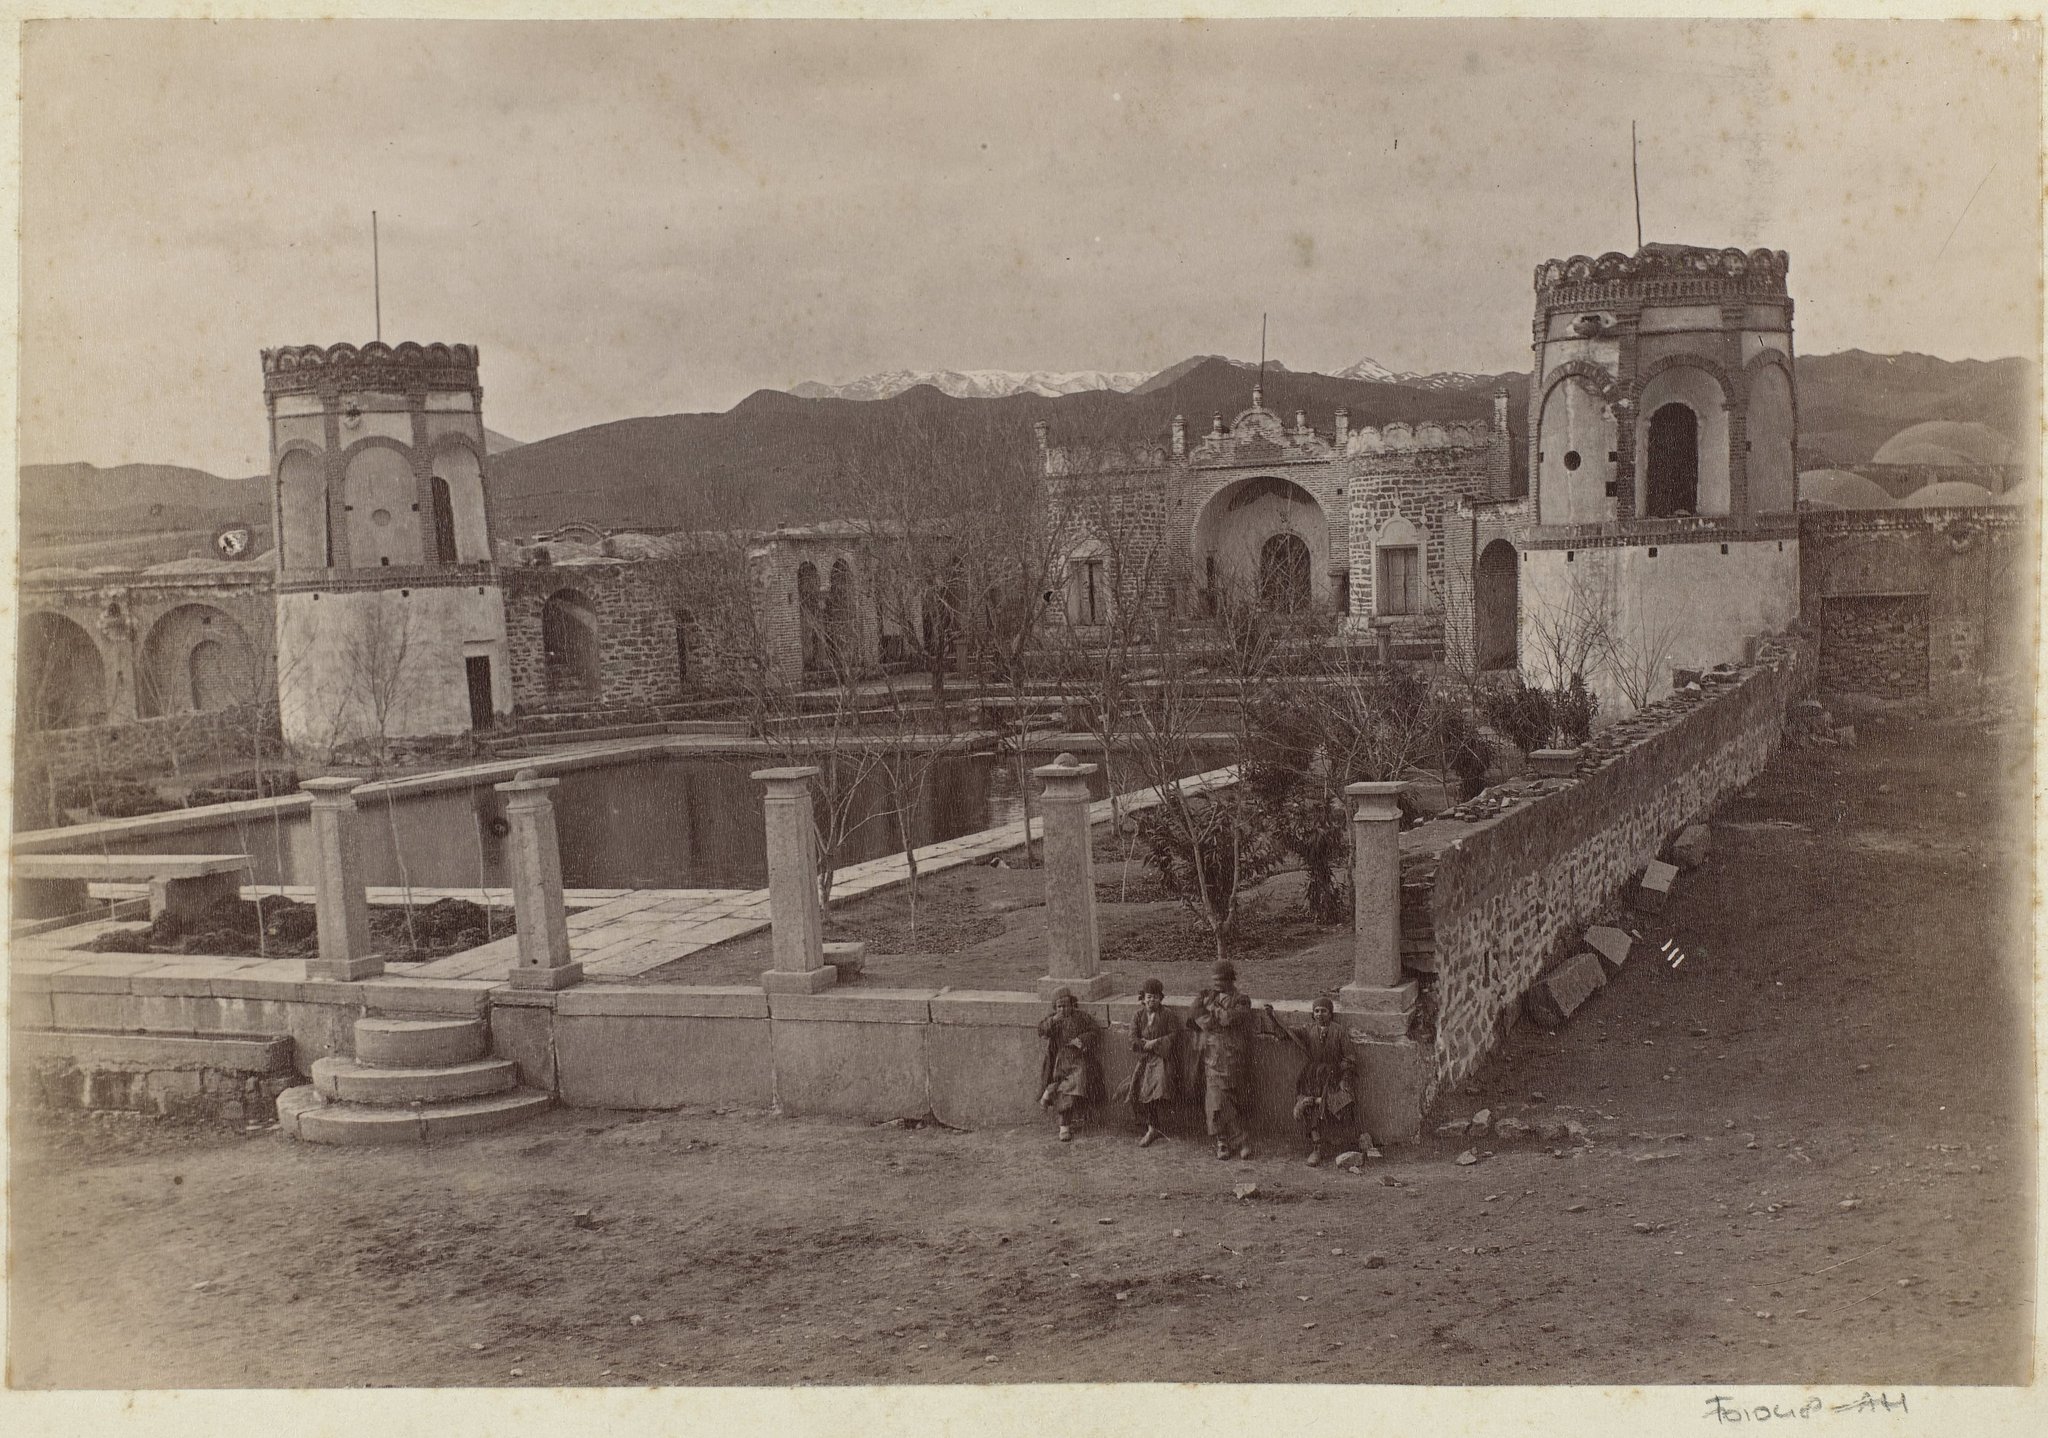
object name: photograph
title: Ommuurde hof in Perzië met een vijver, torens en op de voorgrond kinderen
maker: antoine sevruguin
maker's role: fotograaf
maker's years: 1840-1933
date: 1880-1895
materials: paper, photographic support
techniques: albumen print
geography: iran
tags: courtyard, persia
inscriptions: negative number: ‘111’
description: Onderdeel van Reisalbum van H. Dunlop met foto's van bezienswaardigheden in Perzië, Schotland, Duitsland, Rusland, China en Canada.